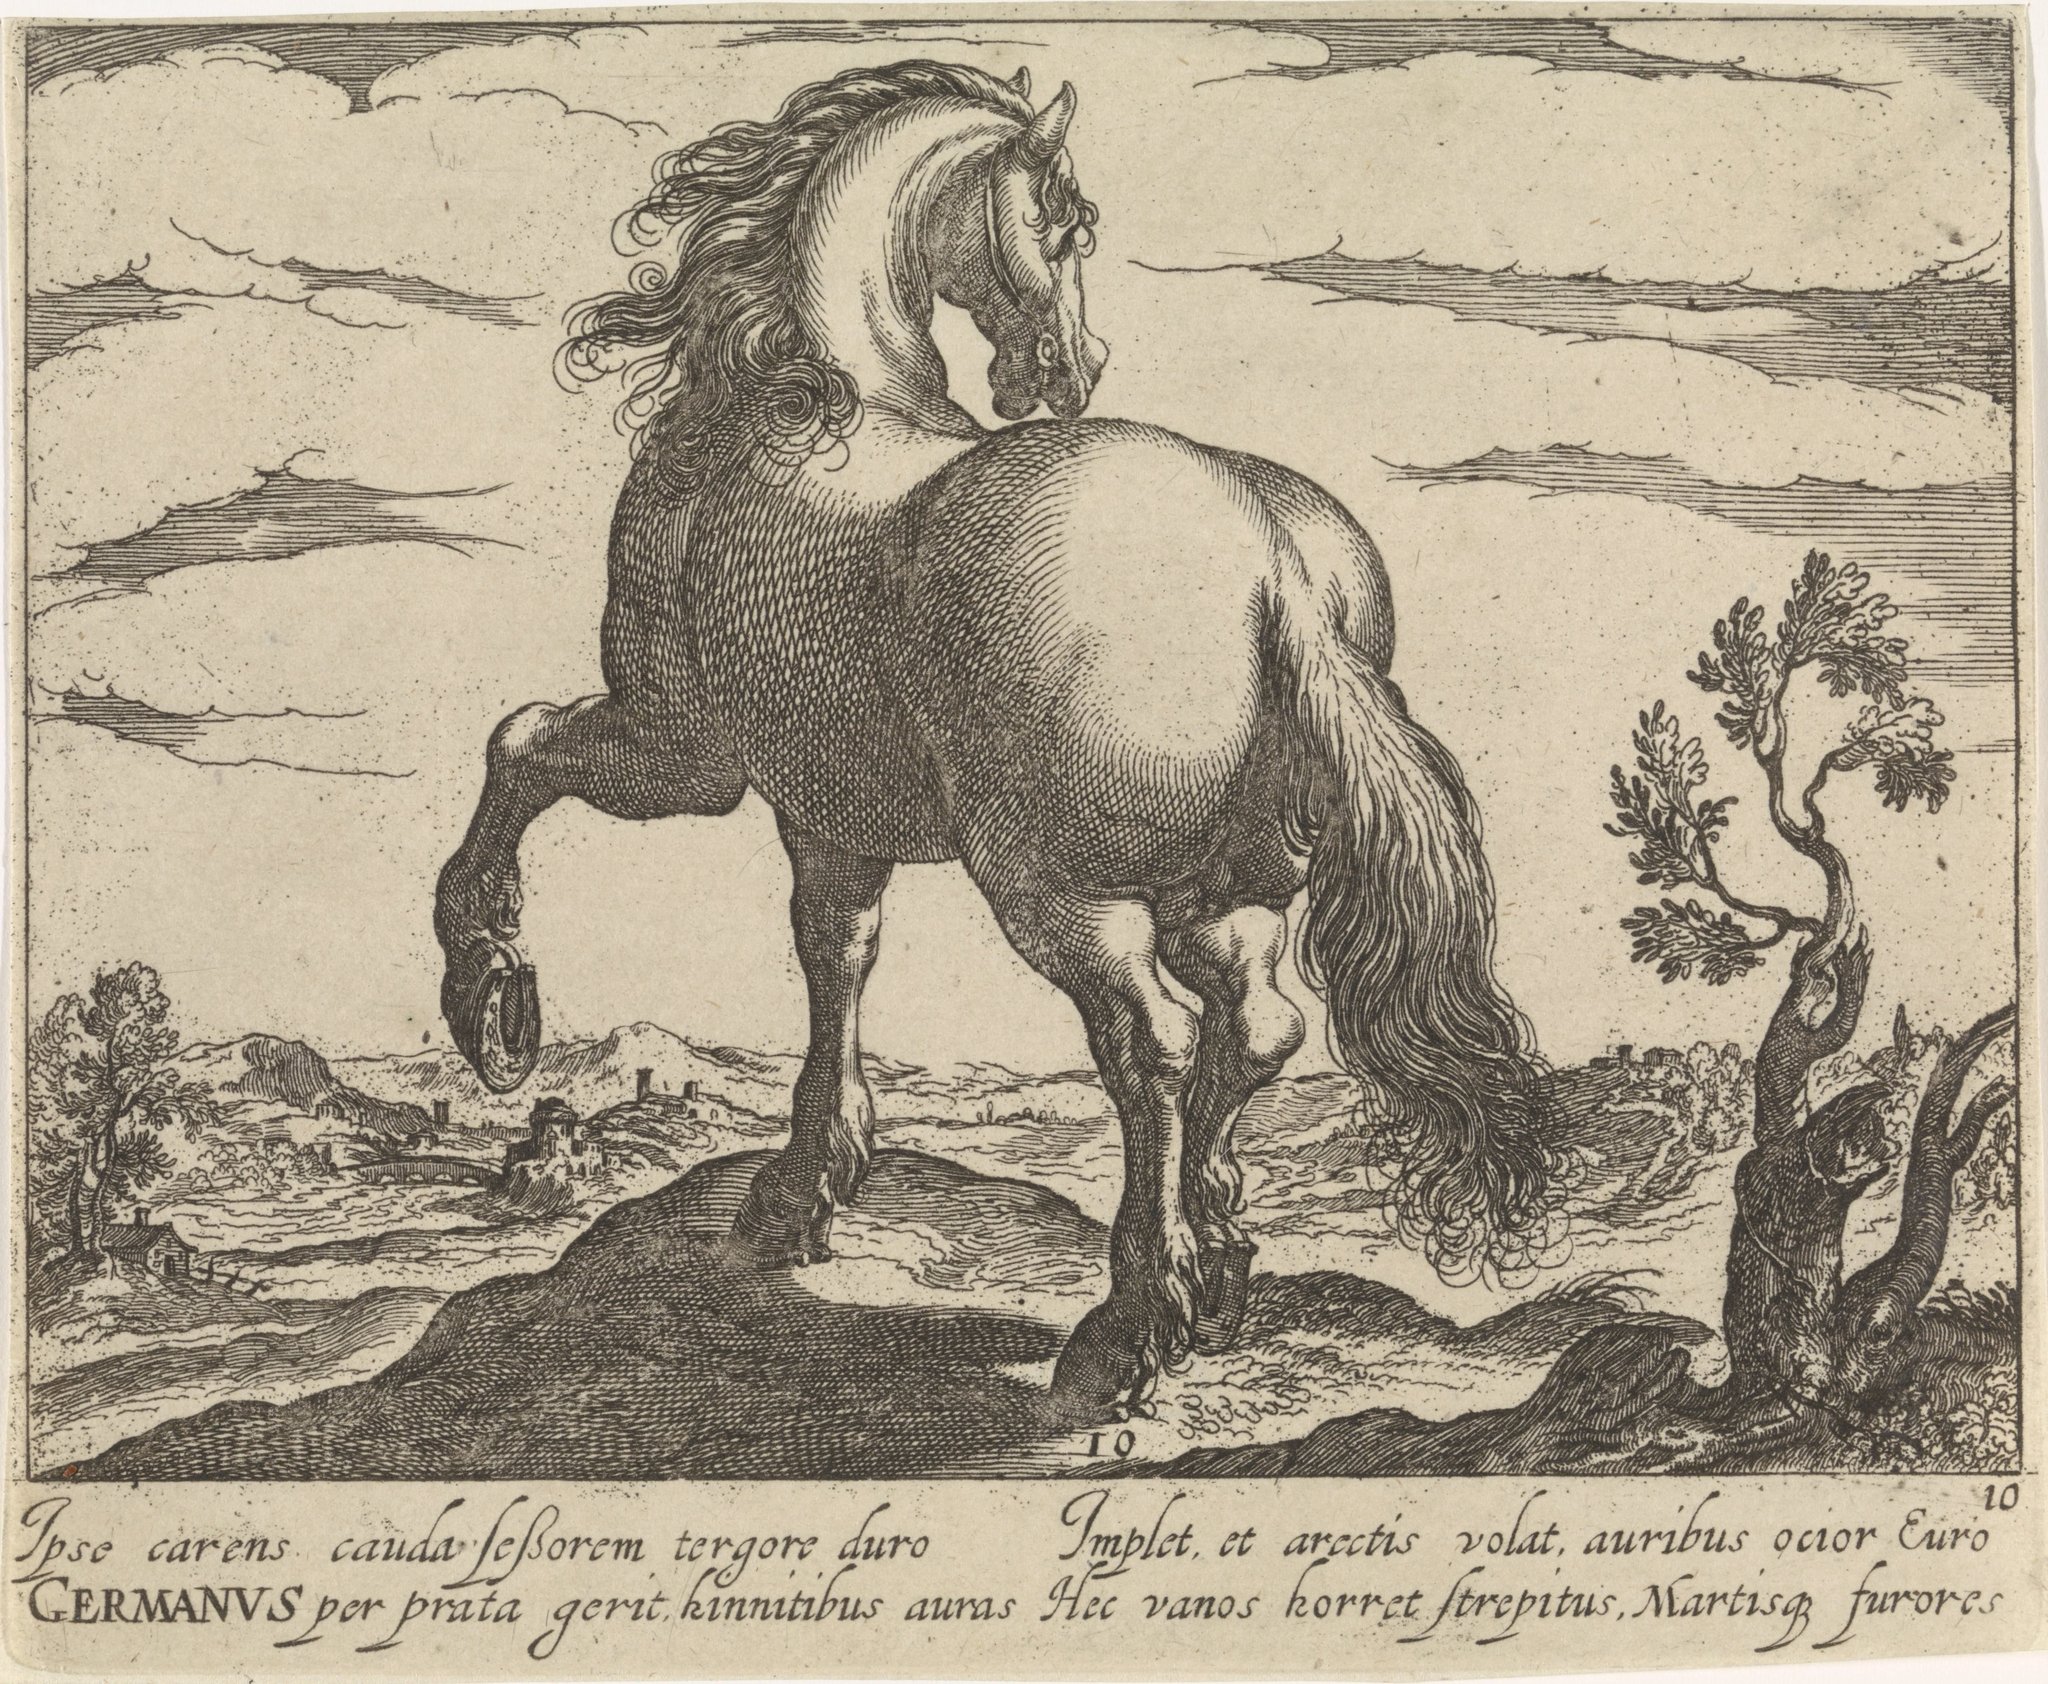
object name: print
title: Paardenrassen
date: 1590-1637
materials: paper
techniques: engraving, etching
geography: amsterdam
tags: horse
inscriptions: collector's mark: Lugt 2228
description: Heuvelachtig landschap met paard, naar links gewend, op de rug gezien. In de marge een tweeregelig onderschrift in het Latijn. Prent uit een serie van dertig met paardenrassen.